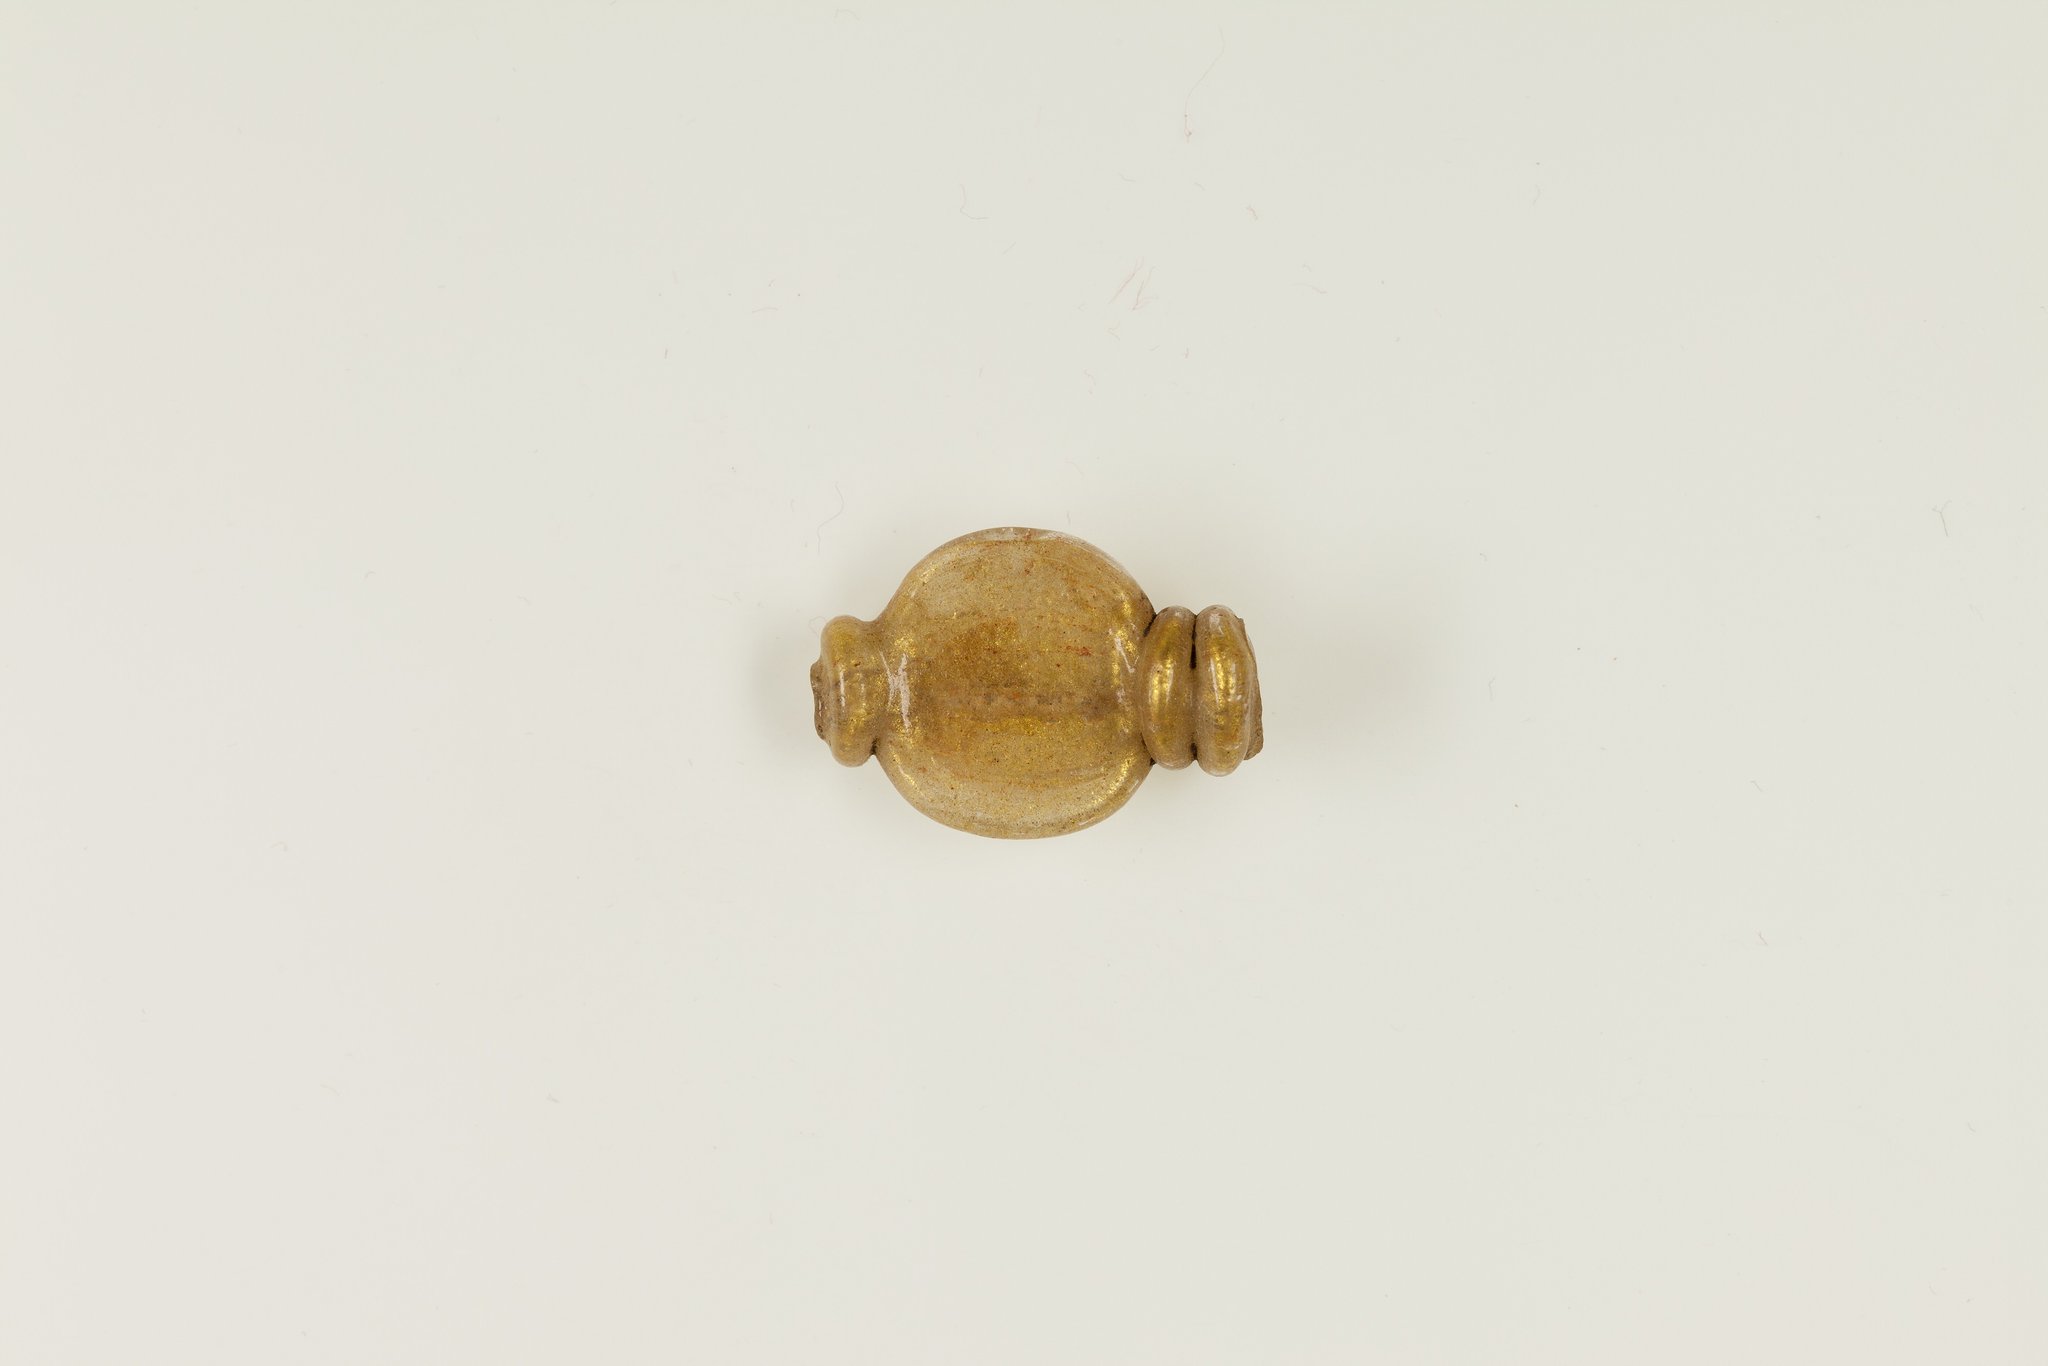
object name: bead, flattened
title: Bead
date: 100 BCE-200 CE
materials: glass, gold foil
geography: egypt